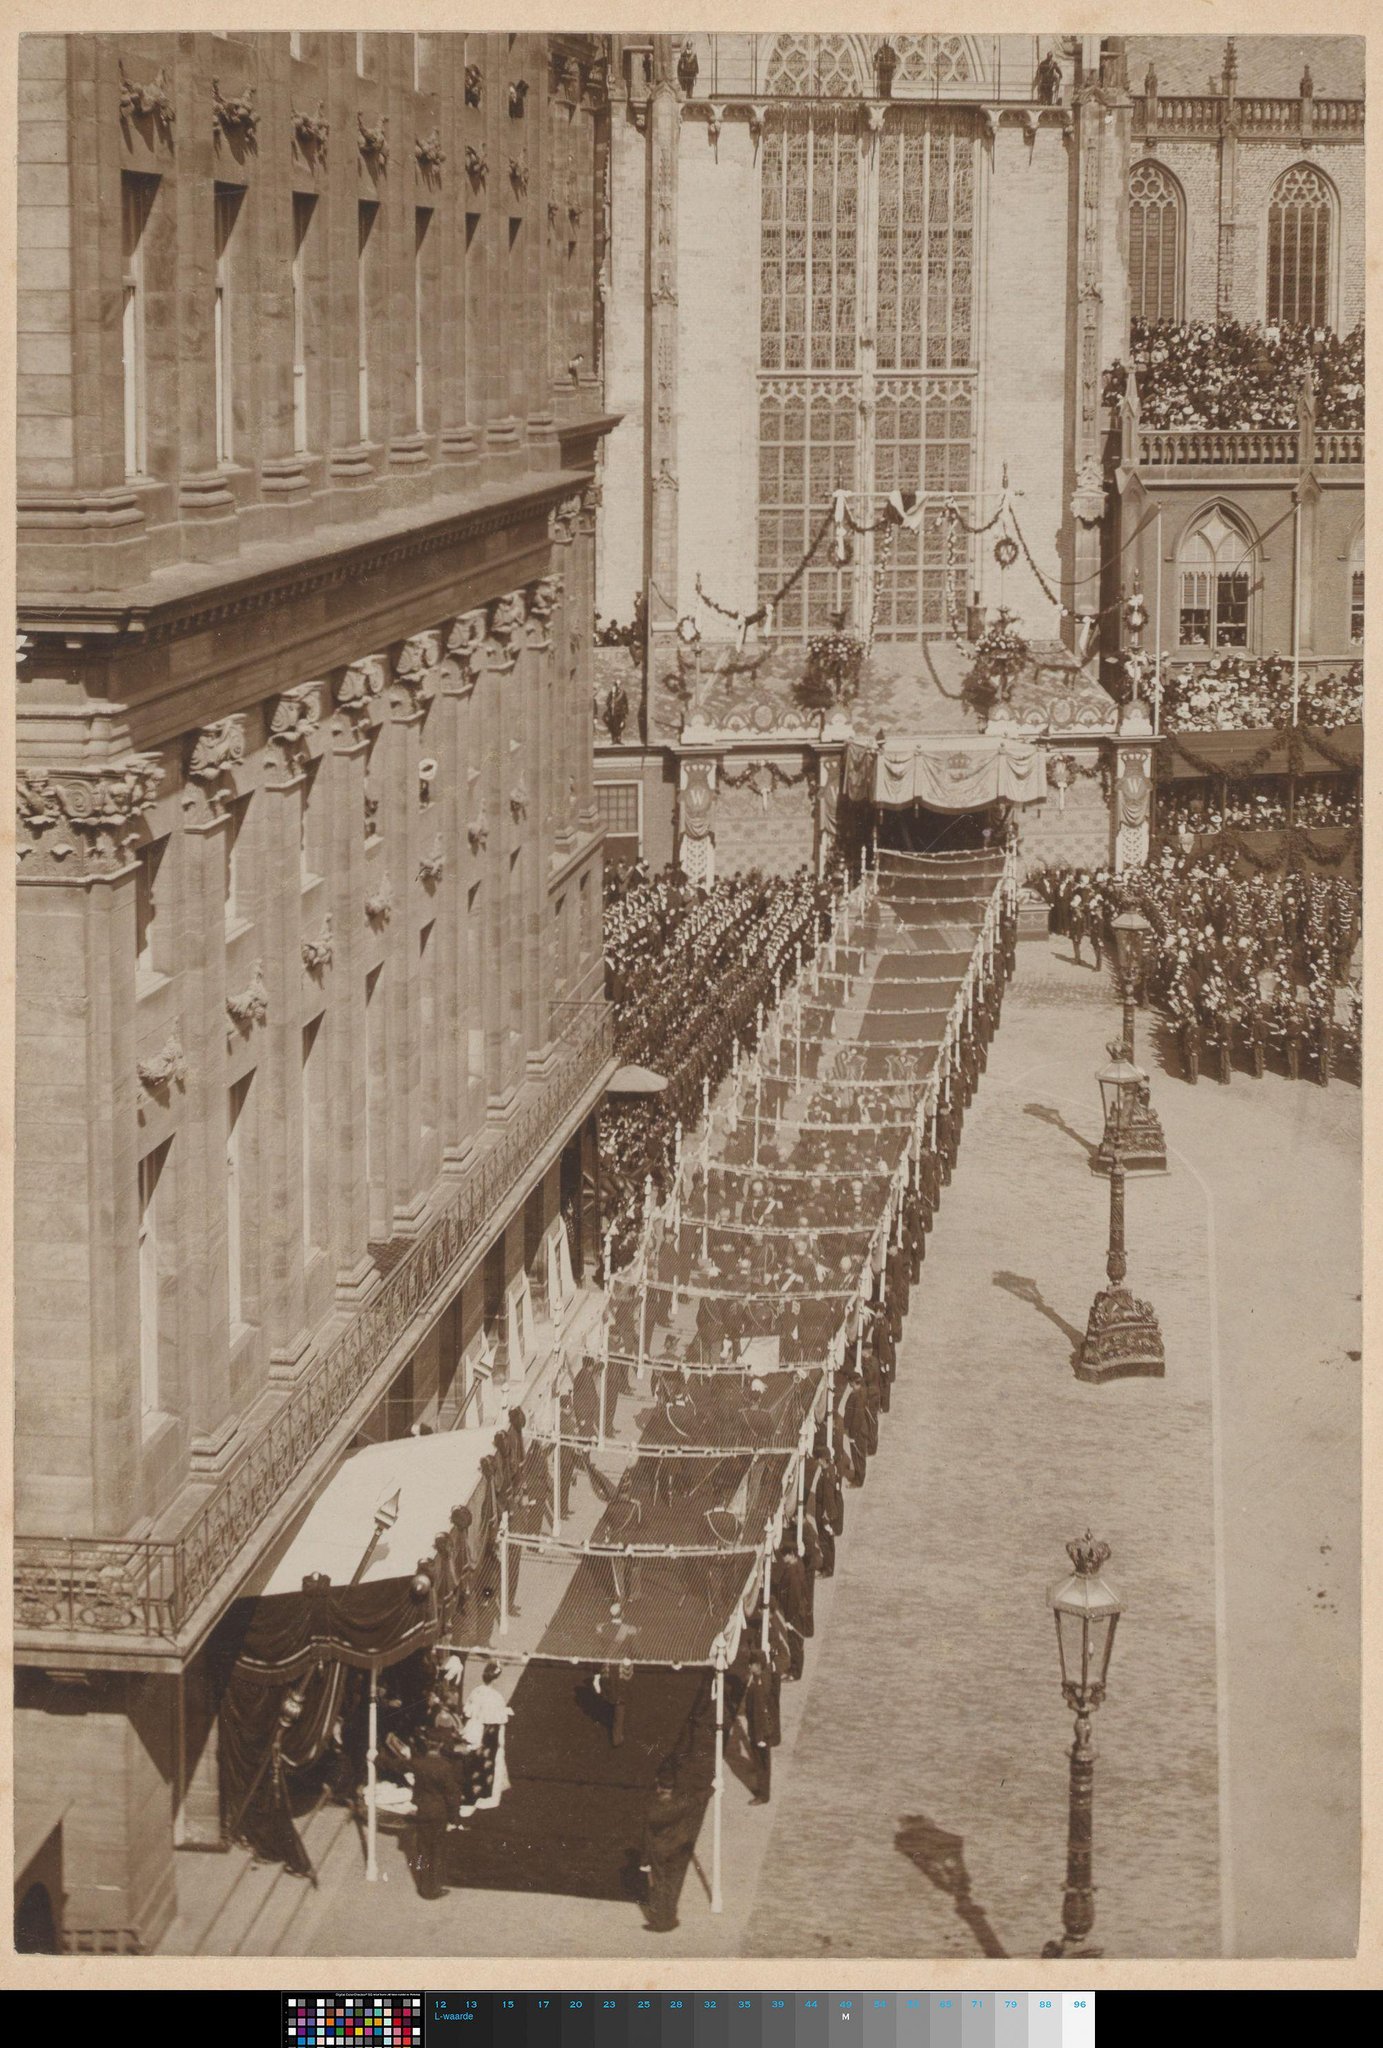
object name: photograph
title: Wilhelmina onder het baldakijn op de Dam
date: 1898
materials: cardboard, paper, photographic support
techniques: collodion silver print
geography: dam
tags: the hague, print maker, wilhelmina of the netherlands, ceremonial celebration of installation of a ruler, public festivities on the occasion of royal events, canopy, baldachin, installation of a ruler - bb - female ruler, palace, church (exterior), guard of honour, mantle, gown, dress (symbol of sovereignty)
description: Tussen het Koninklijk Paleis en de Nieuwe Kerk is een baldakijn aangebracht. Aan weerszijden daarvan 32 cadetten van de Koninklijke Militaire Academie en adelborsten van de Koninklijke Nederlandse Marine. Op de voorgrond verlaat Wilhelmina het Koninklijk Paleis om zich naar de Nieuwe Kerk te begeven. Onderdeel van Fotoalbum met 11 opnames van de inhuldiging van Koningin Wilhelmina en de inhuldigingsfeesten.